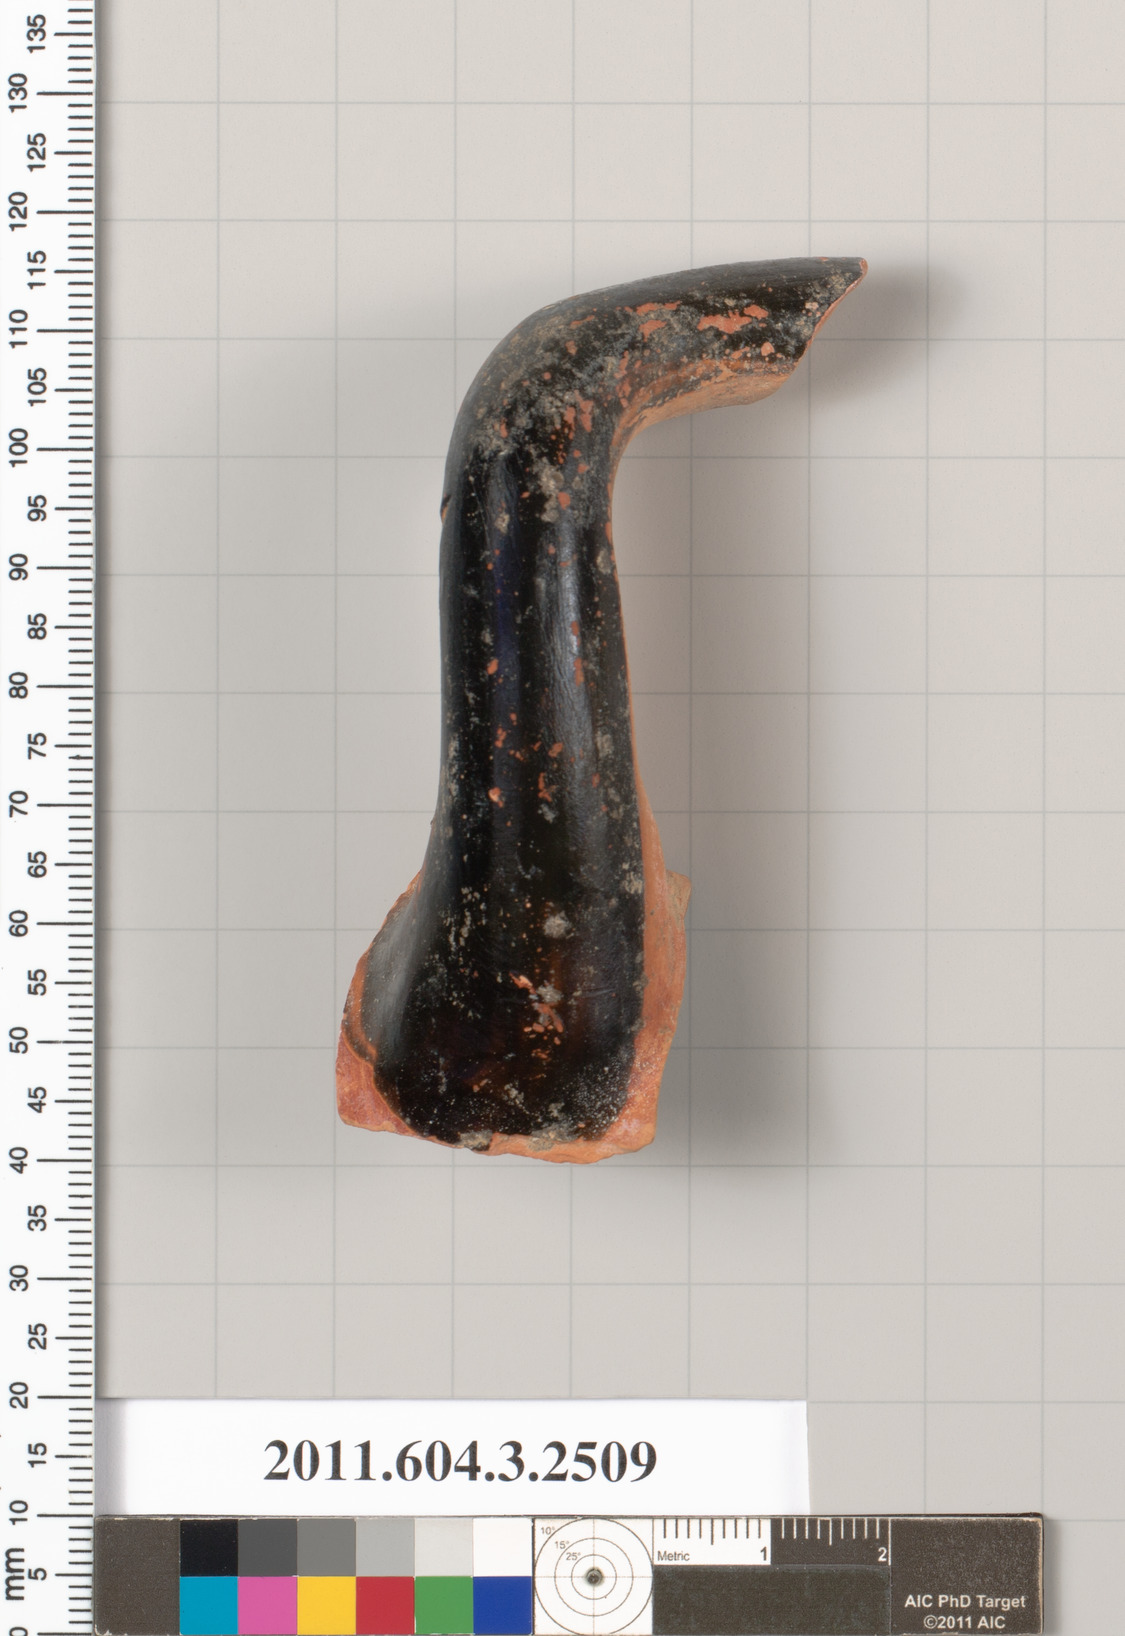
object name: kylix fragment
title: Terracotta fragment of a kylix (drinking cup)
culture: greek, attic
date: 600-401 BCE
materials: terracotta